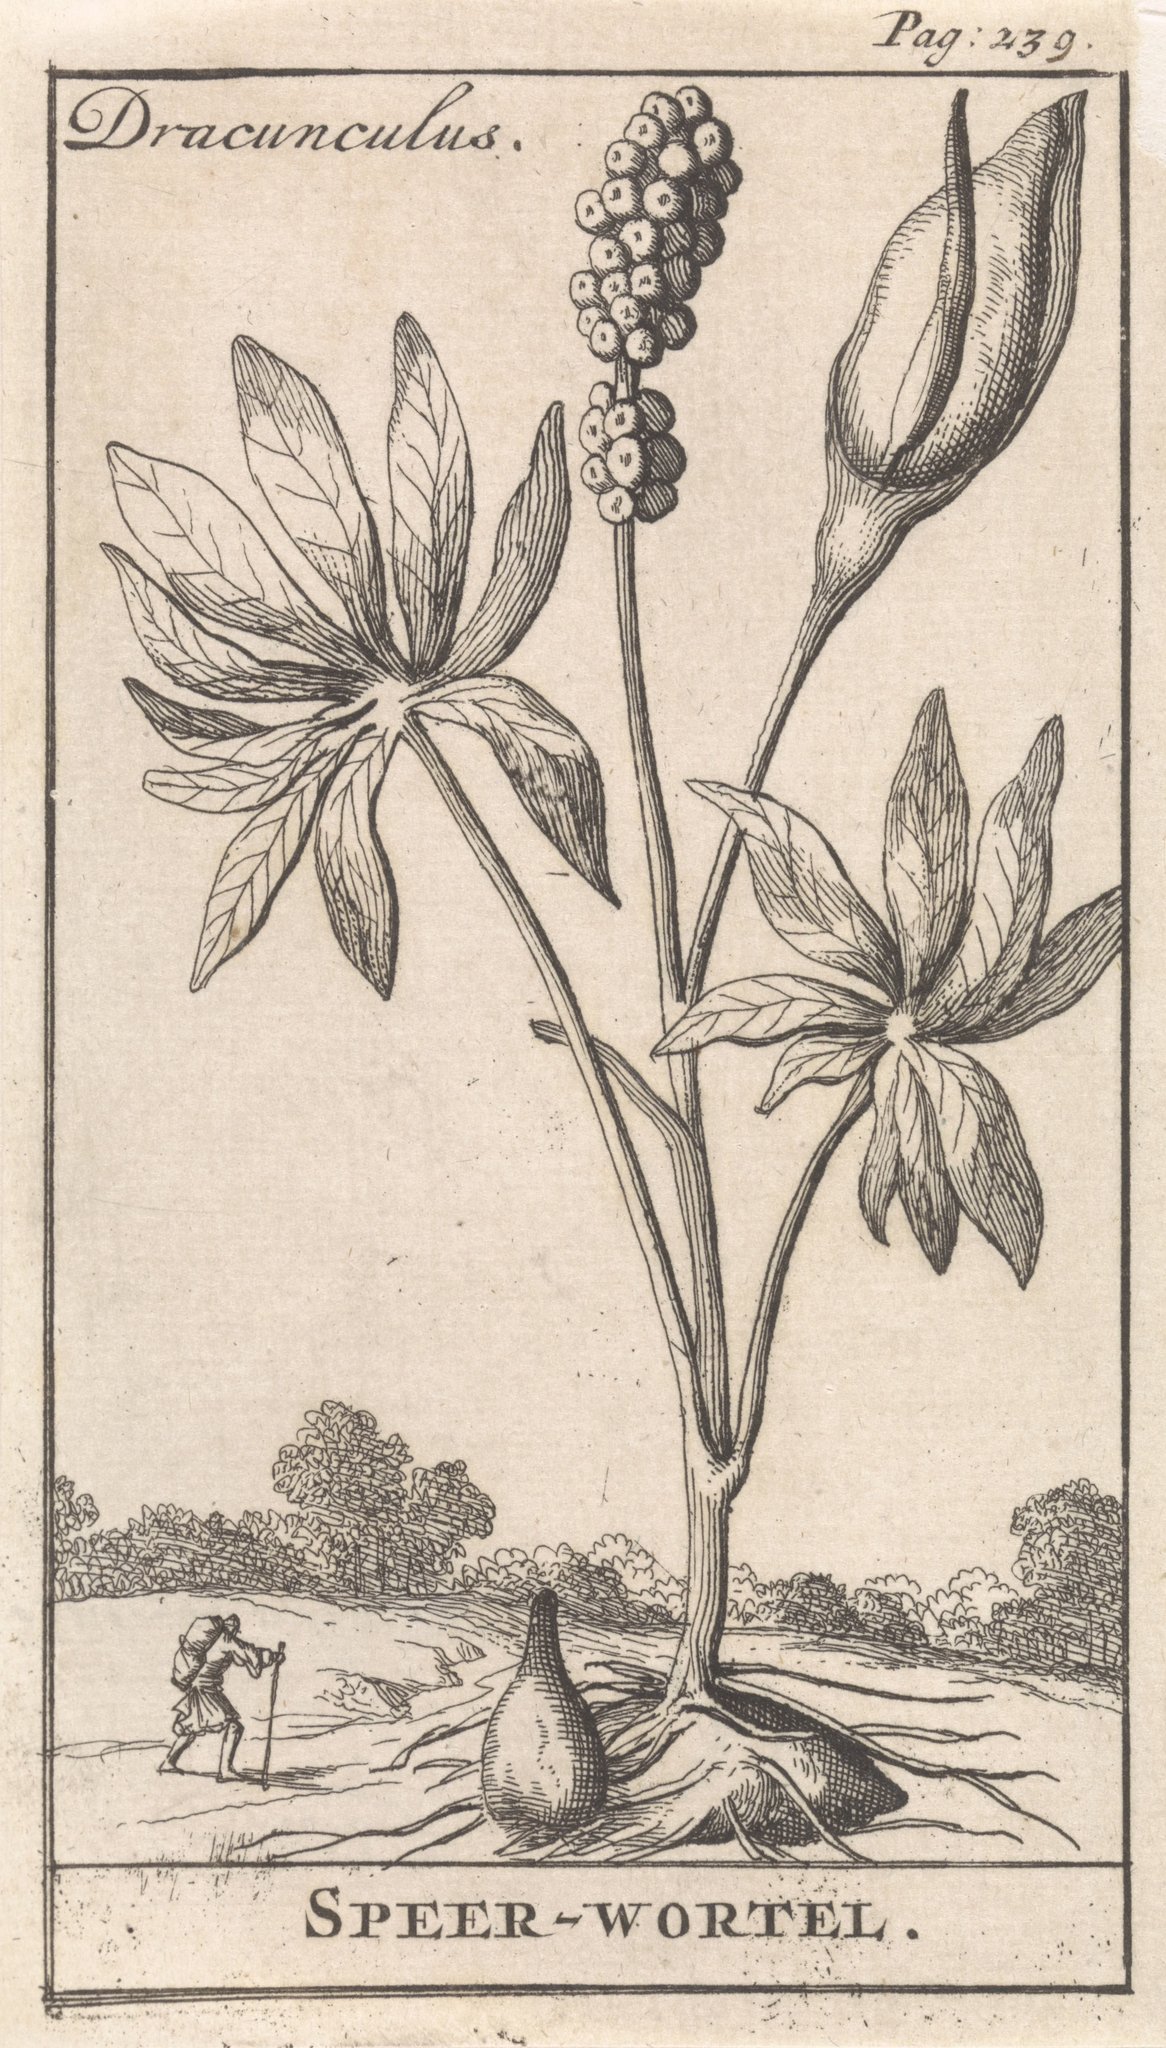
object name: book illustration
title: Dracunculus / Speer-wortel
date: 1698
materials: paper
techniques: etching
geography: amsterdam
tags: plants and herbs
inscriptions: collector's mark: Lugt 2228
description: Illustratie uit: Blankaart, Steven. Den Neder-landschen herbarius ofte Kruid-boek der voornaamste kruiden. Amsterdam: Jan Claesz ten Hoorn, 1698.